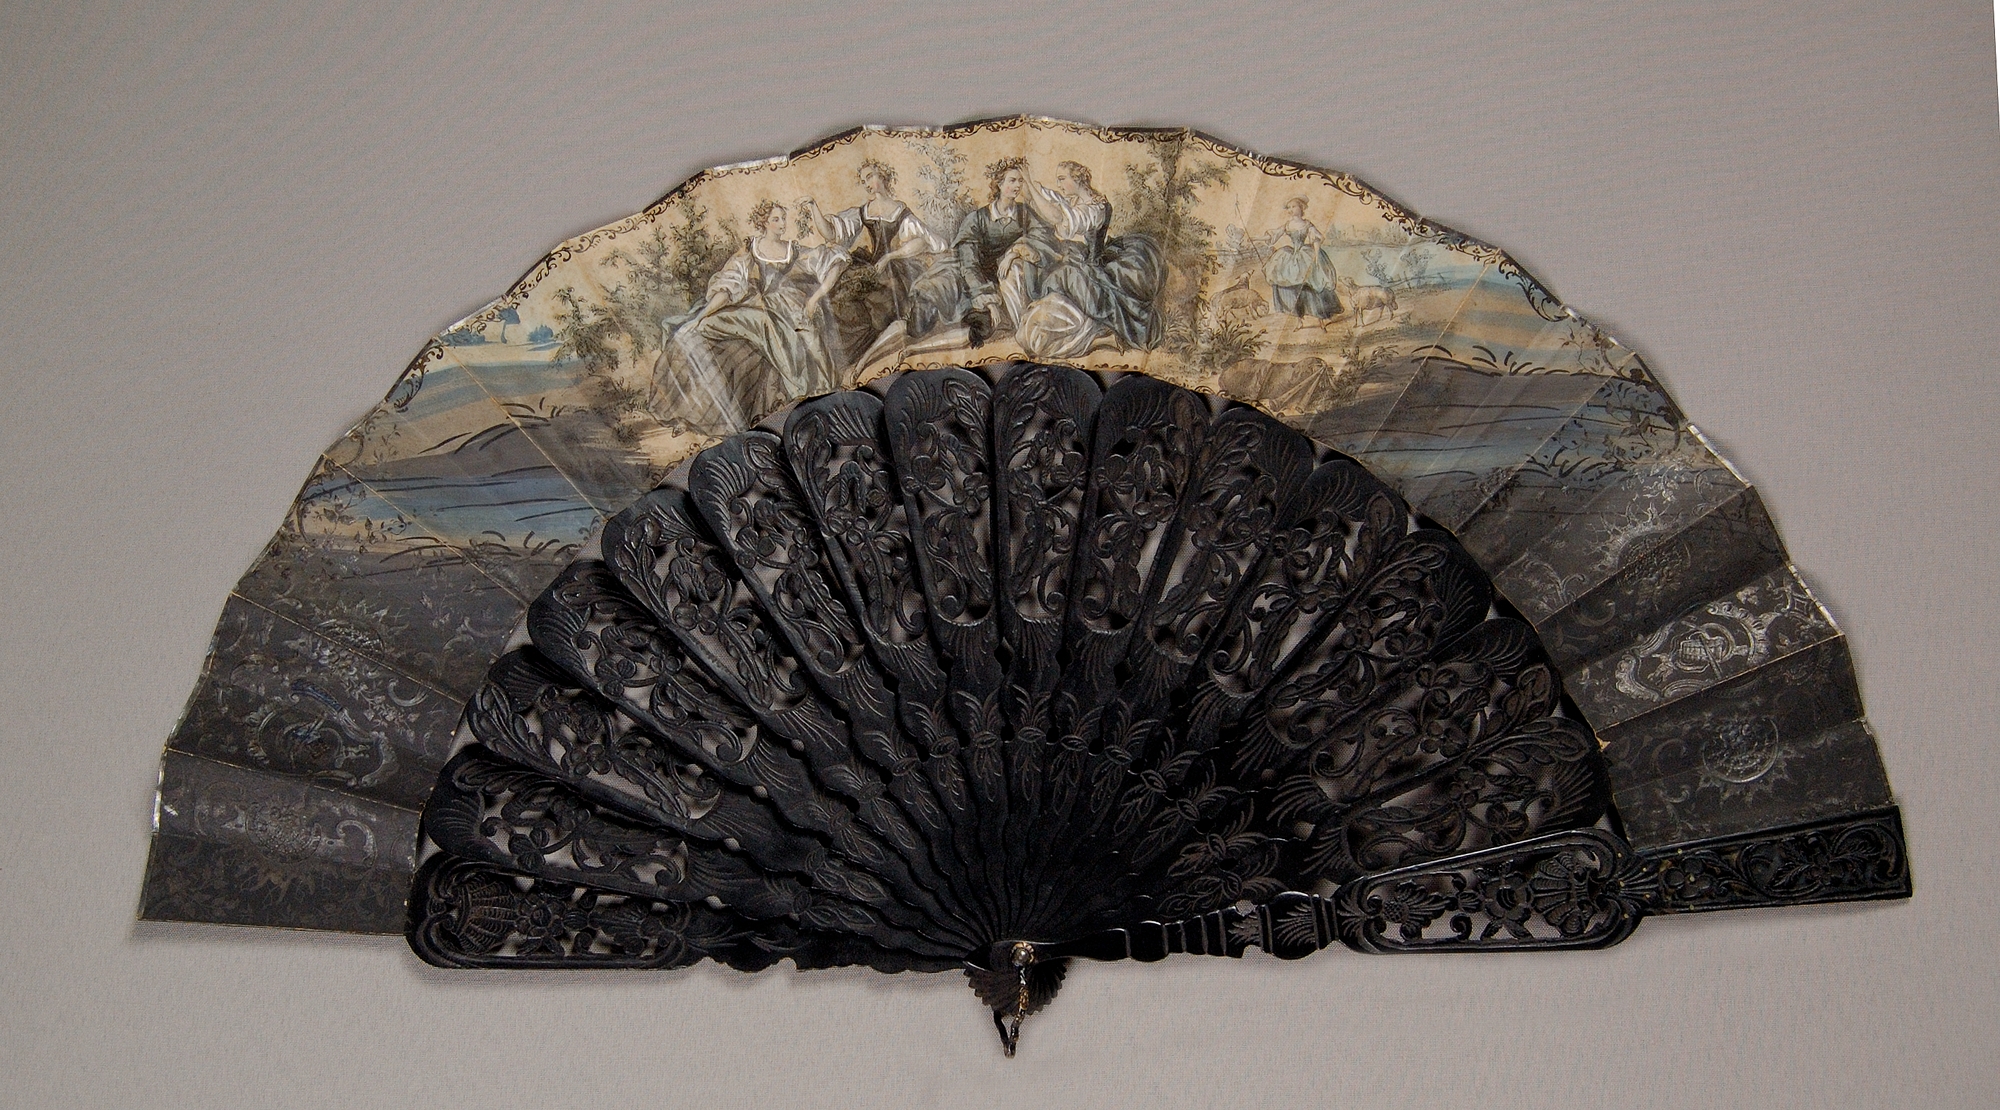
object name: fan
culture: spanish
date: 1850-1869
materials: metal, paper, wood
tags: men,women